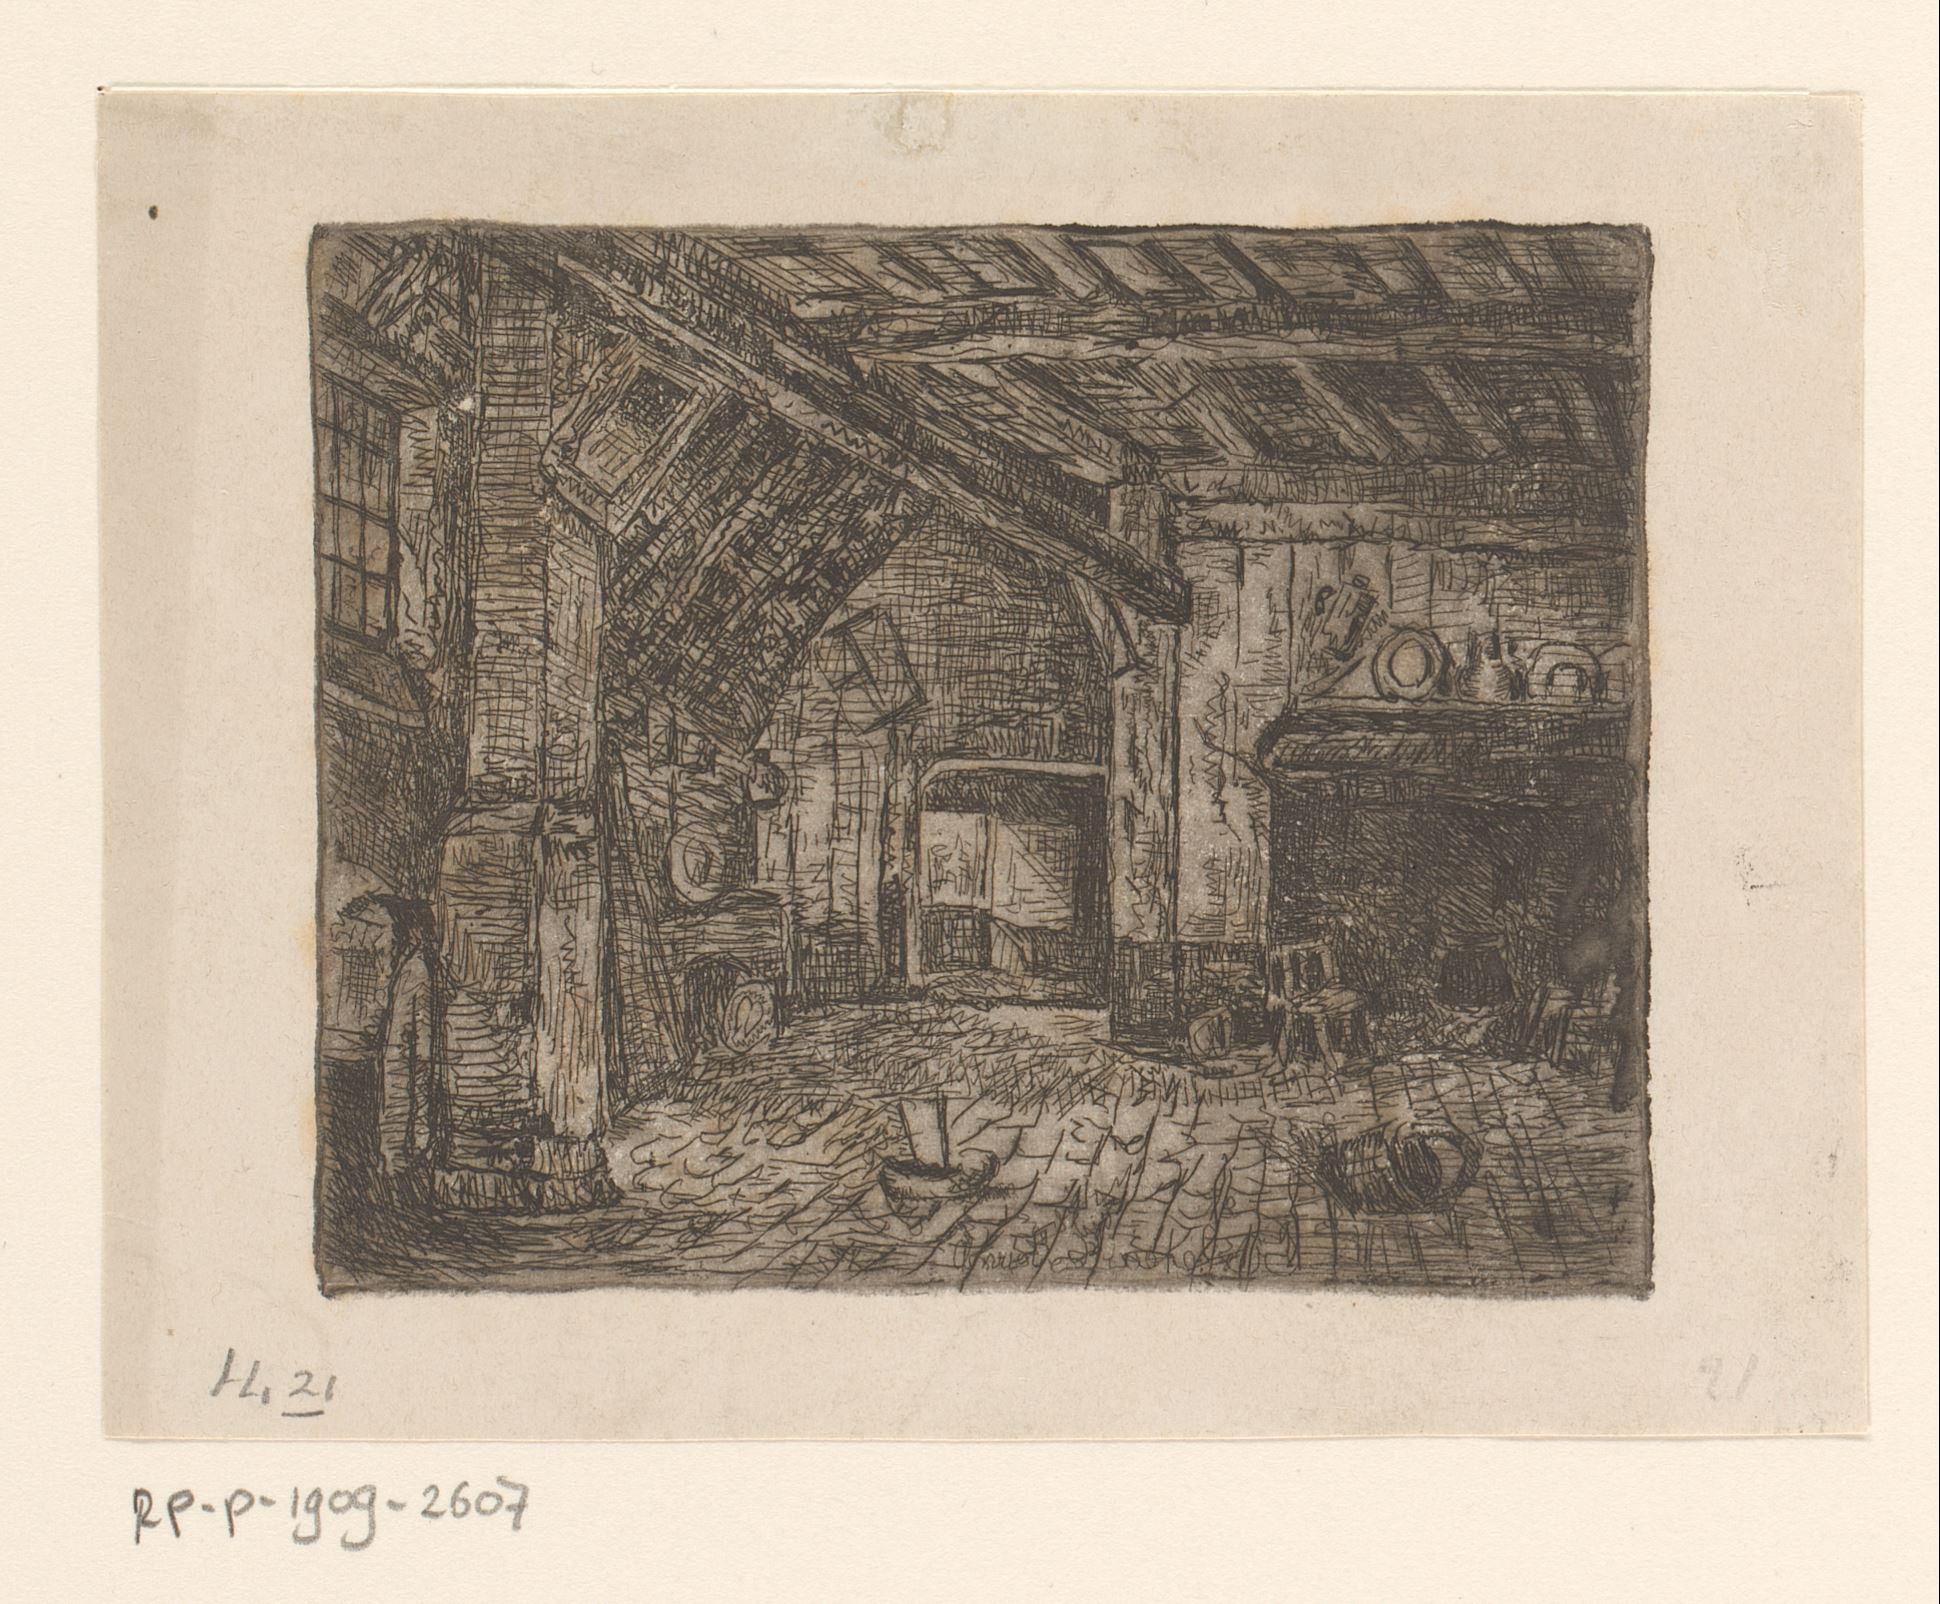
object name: print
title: Interieur met haard en balkenplafond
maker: henri de braekeleer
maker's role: draughtsman, print maker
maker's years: 1840-1888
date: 1850-1879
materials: paper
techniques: etching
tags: interior ~ representation of a building, open fire, fire-place, stove (in kitchen)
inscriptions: collector's mark: Lugt 1485, collector's mark: Lugt 2228